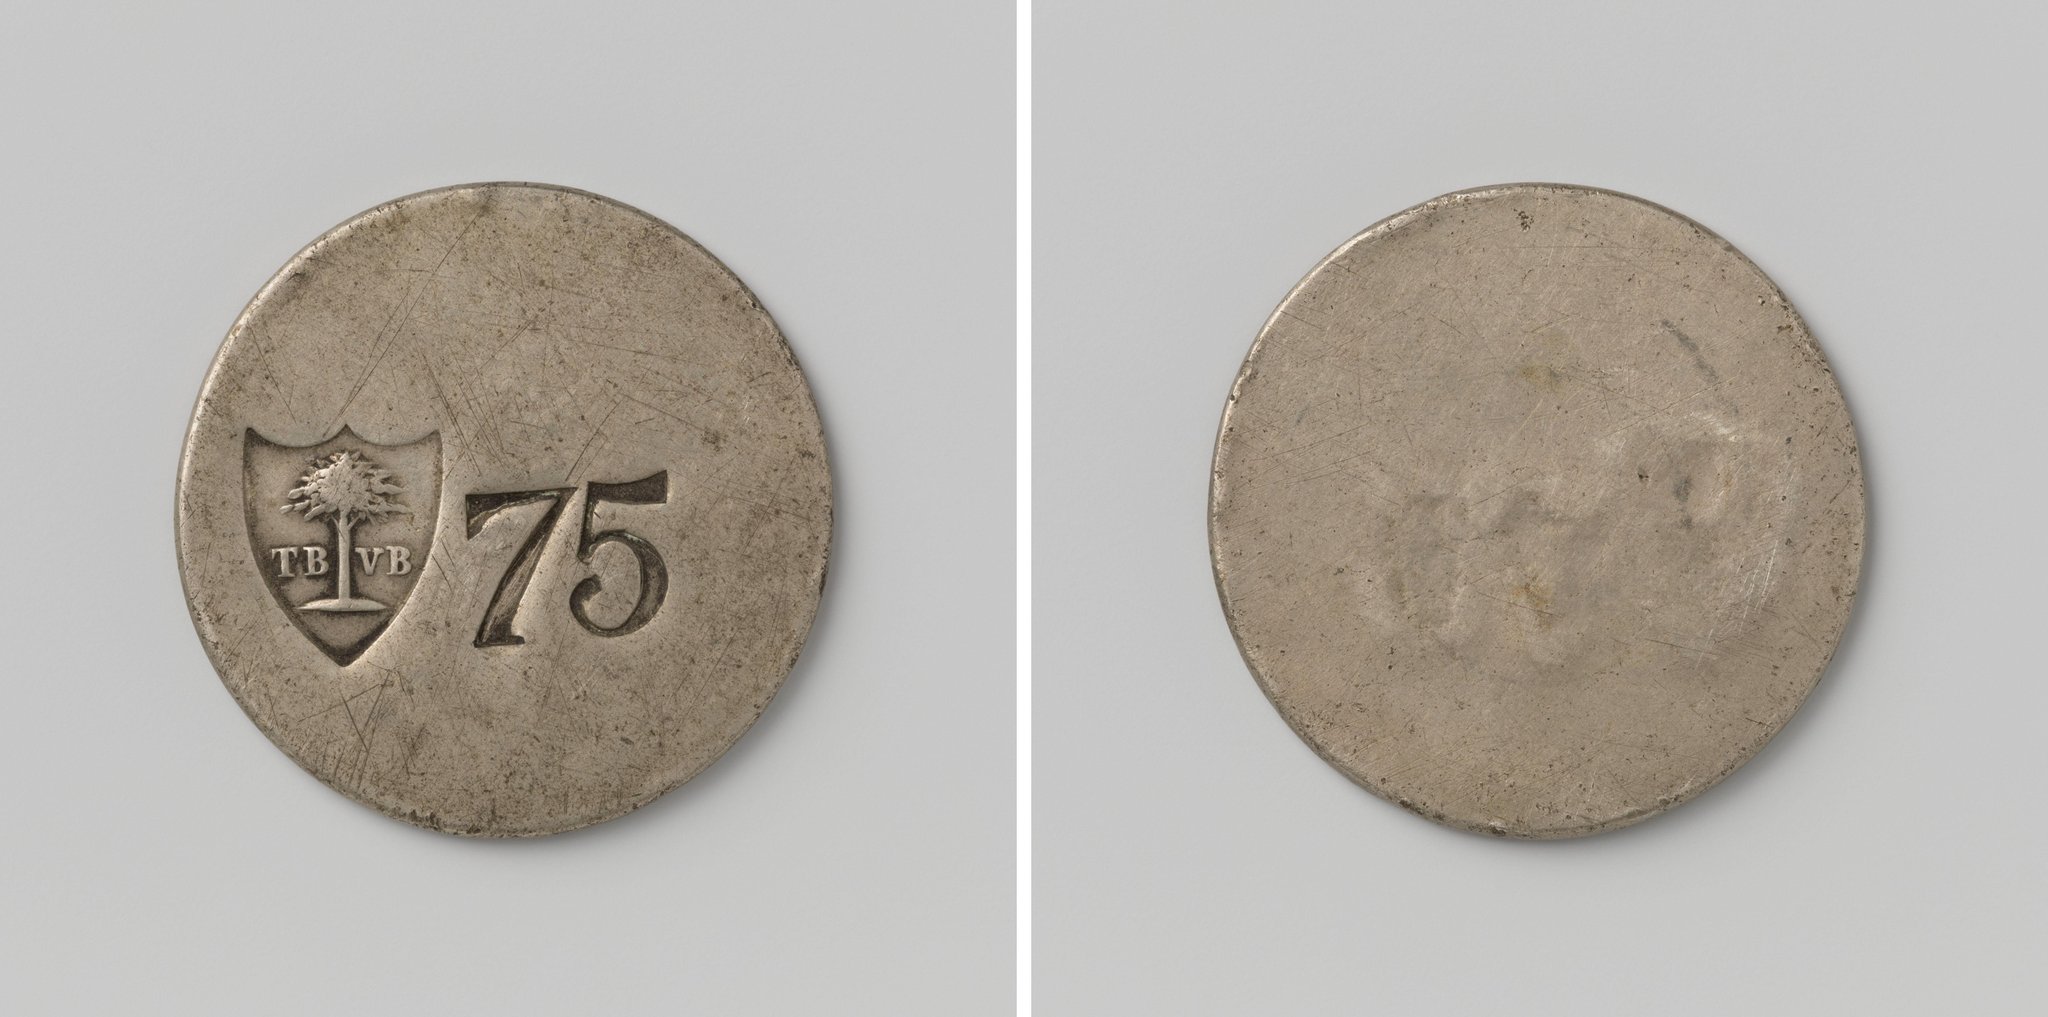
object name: medal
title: Penning met no. 75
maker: Anonymous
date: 1700-1800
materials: silver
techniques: striking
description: Eenzijdige zilveren penning. Voorzijde: twee stempels, links: schild met daarin boom tussen monogram TB en VB; rechts: cijfer 75. Keerzijde: blanco